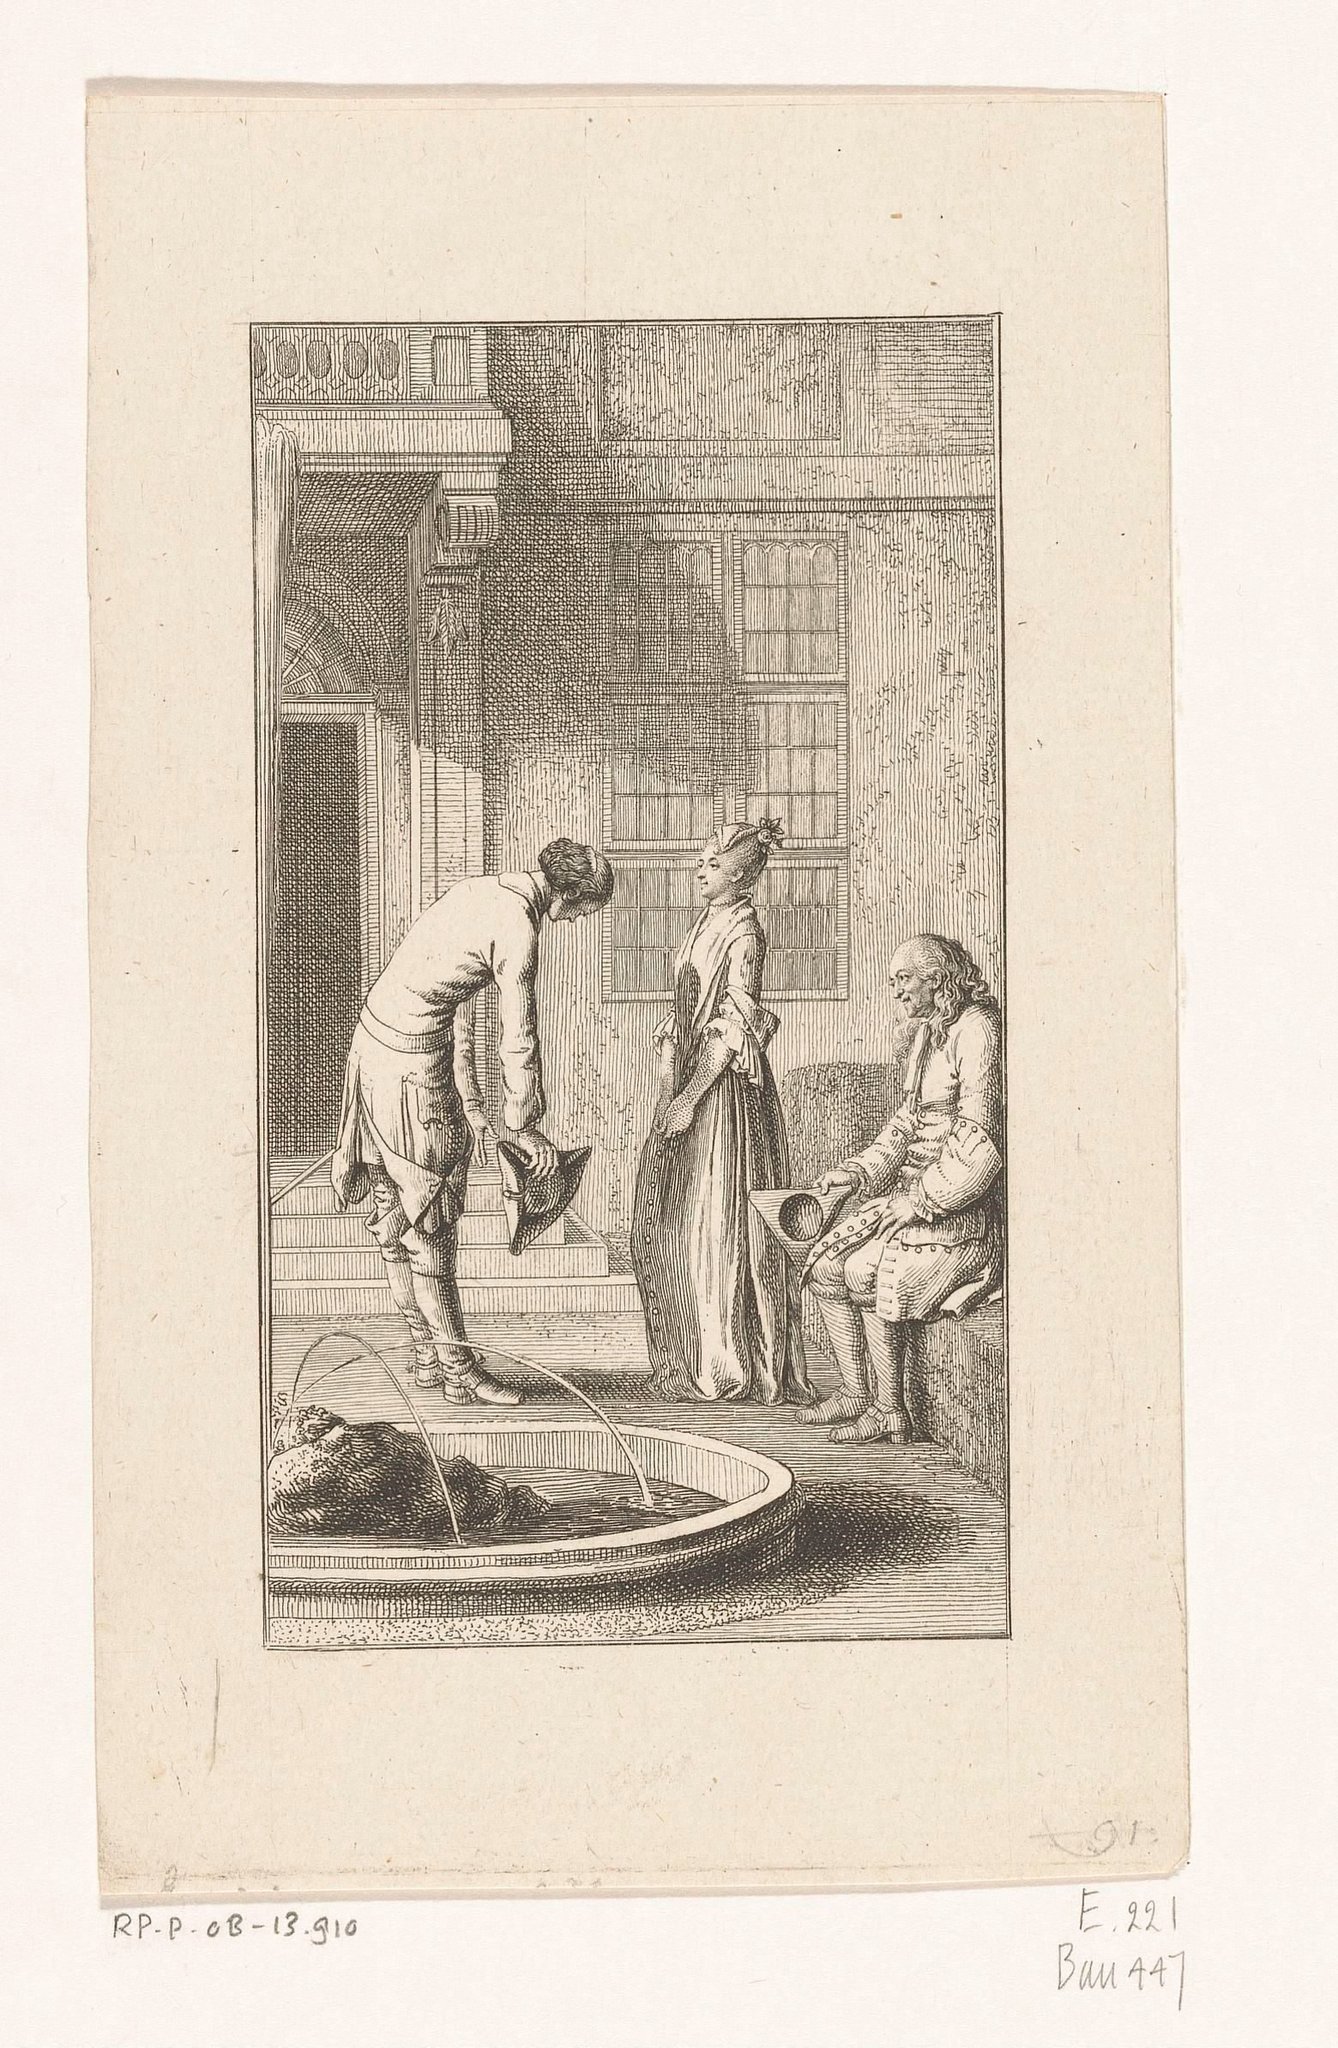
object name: print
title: John Buncle bij Miss Henley en haar grootvader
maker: daniel nikolaus chodowiecki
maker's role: draughtsman, print maker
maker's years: 1726-1801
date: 1778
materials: paper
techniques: etching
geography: berlin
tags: literature, baring the head, lifting one's hat, garden fountain, head bent forward; bowing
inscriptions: collector's mark: Lugt 2228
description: Een latere staat van deze prent is ook gebruikt in: Leben, Bemerkungen und Meinungen Johann Bunkels, nebst den Leben verscheidener merkwürdiger Frauenzimmer. 4 dln. Berlijn: Friedrich Nicolai, 1778. De Engelse uitgave verscheen tussen 1756-1766 onder de titel 'The life of John Buncle' en wordt meestal toegeschreven aan Thomas Armory. Chodowiecki etste in totaal 16 scènes voor dit werk.